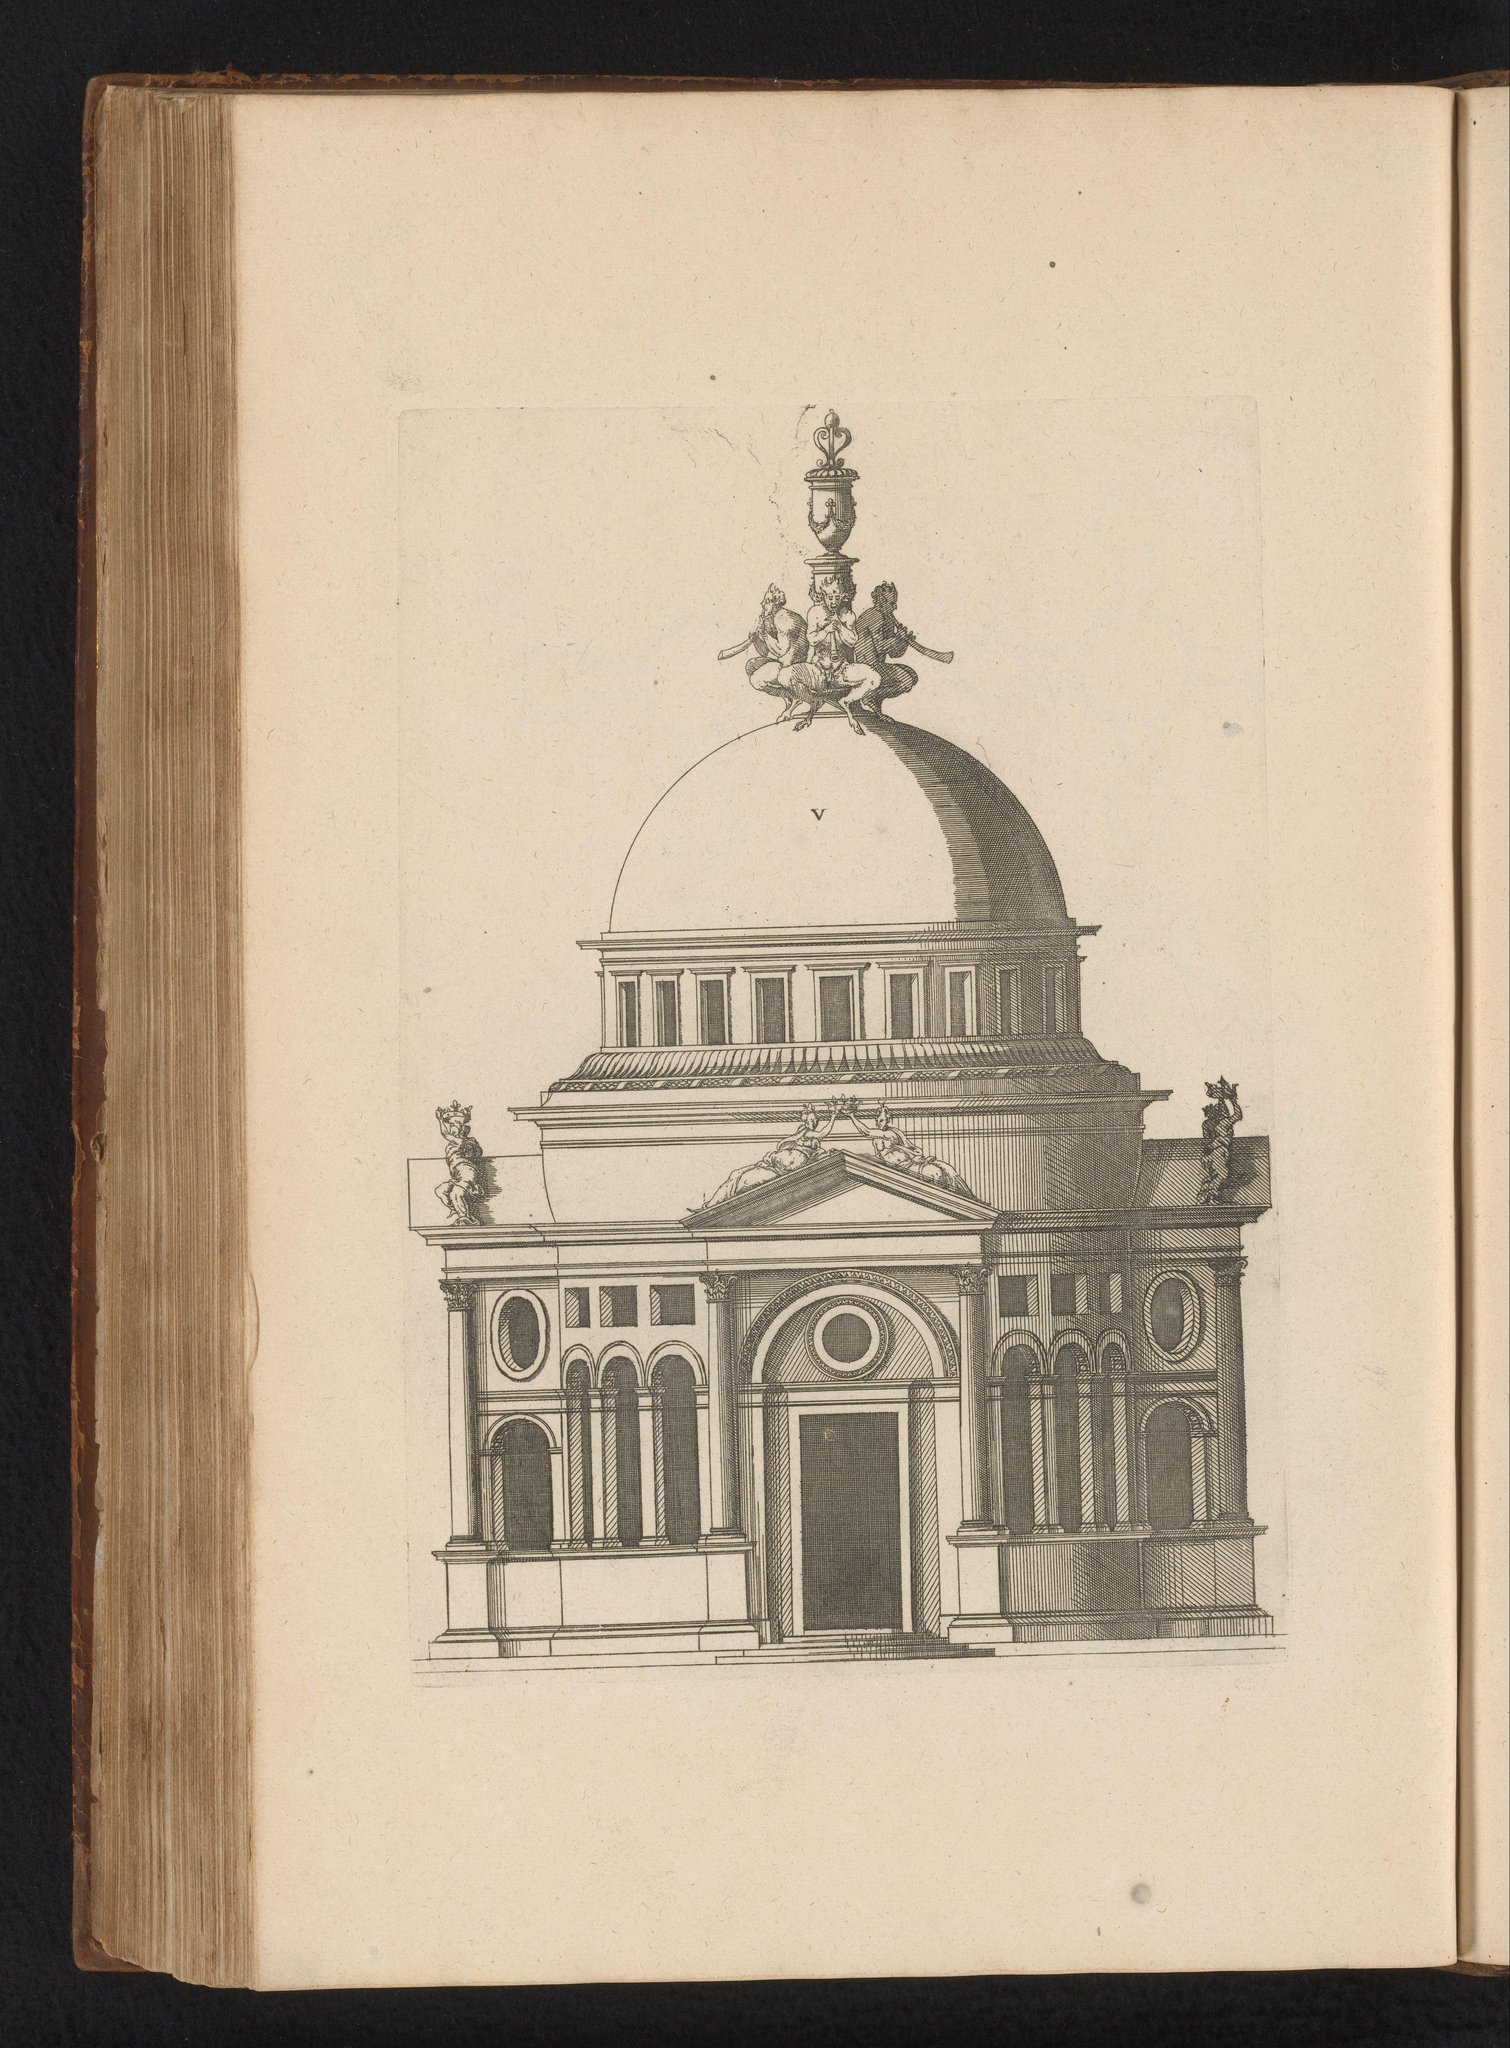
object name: ornament print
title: Gebouw met koepel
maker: jacques androuet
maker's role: draughtsman, print maker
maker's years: 1515-1584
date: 1561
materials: paper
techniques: etching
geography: paris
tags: architectural design or model, dome ~ architecture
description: Gebouw met koepel. Onderdeel van 'Seconde livre d'architectvre' (1561): 64 etsen met geornamenteerde architectuuronderdelen.